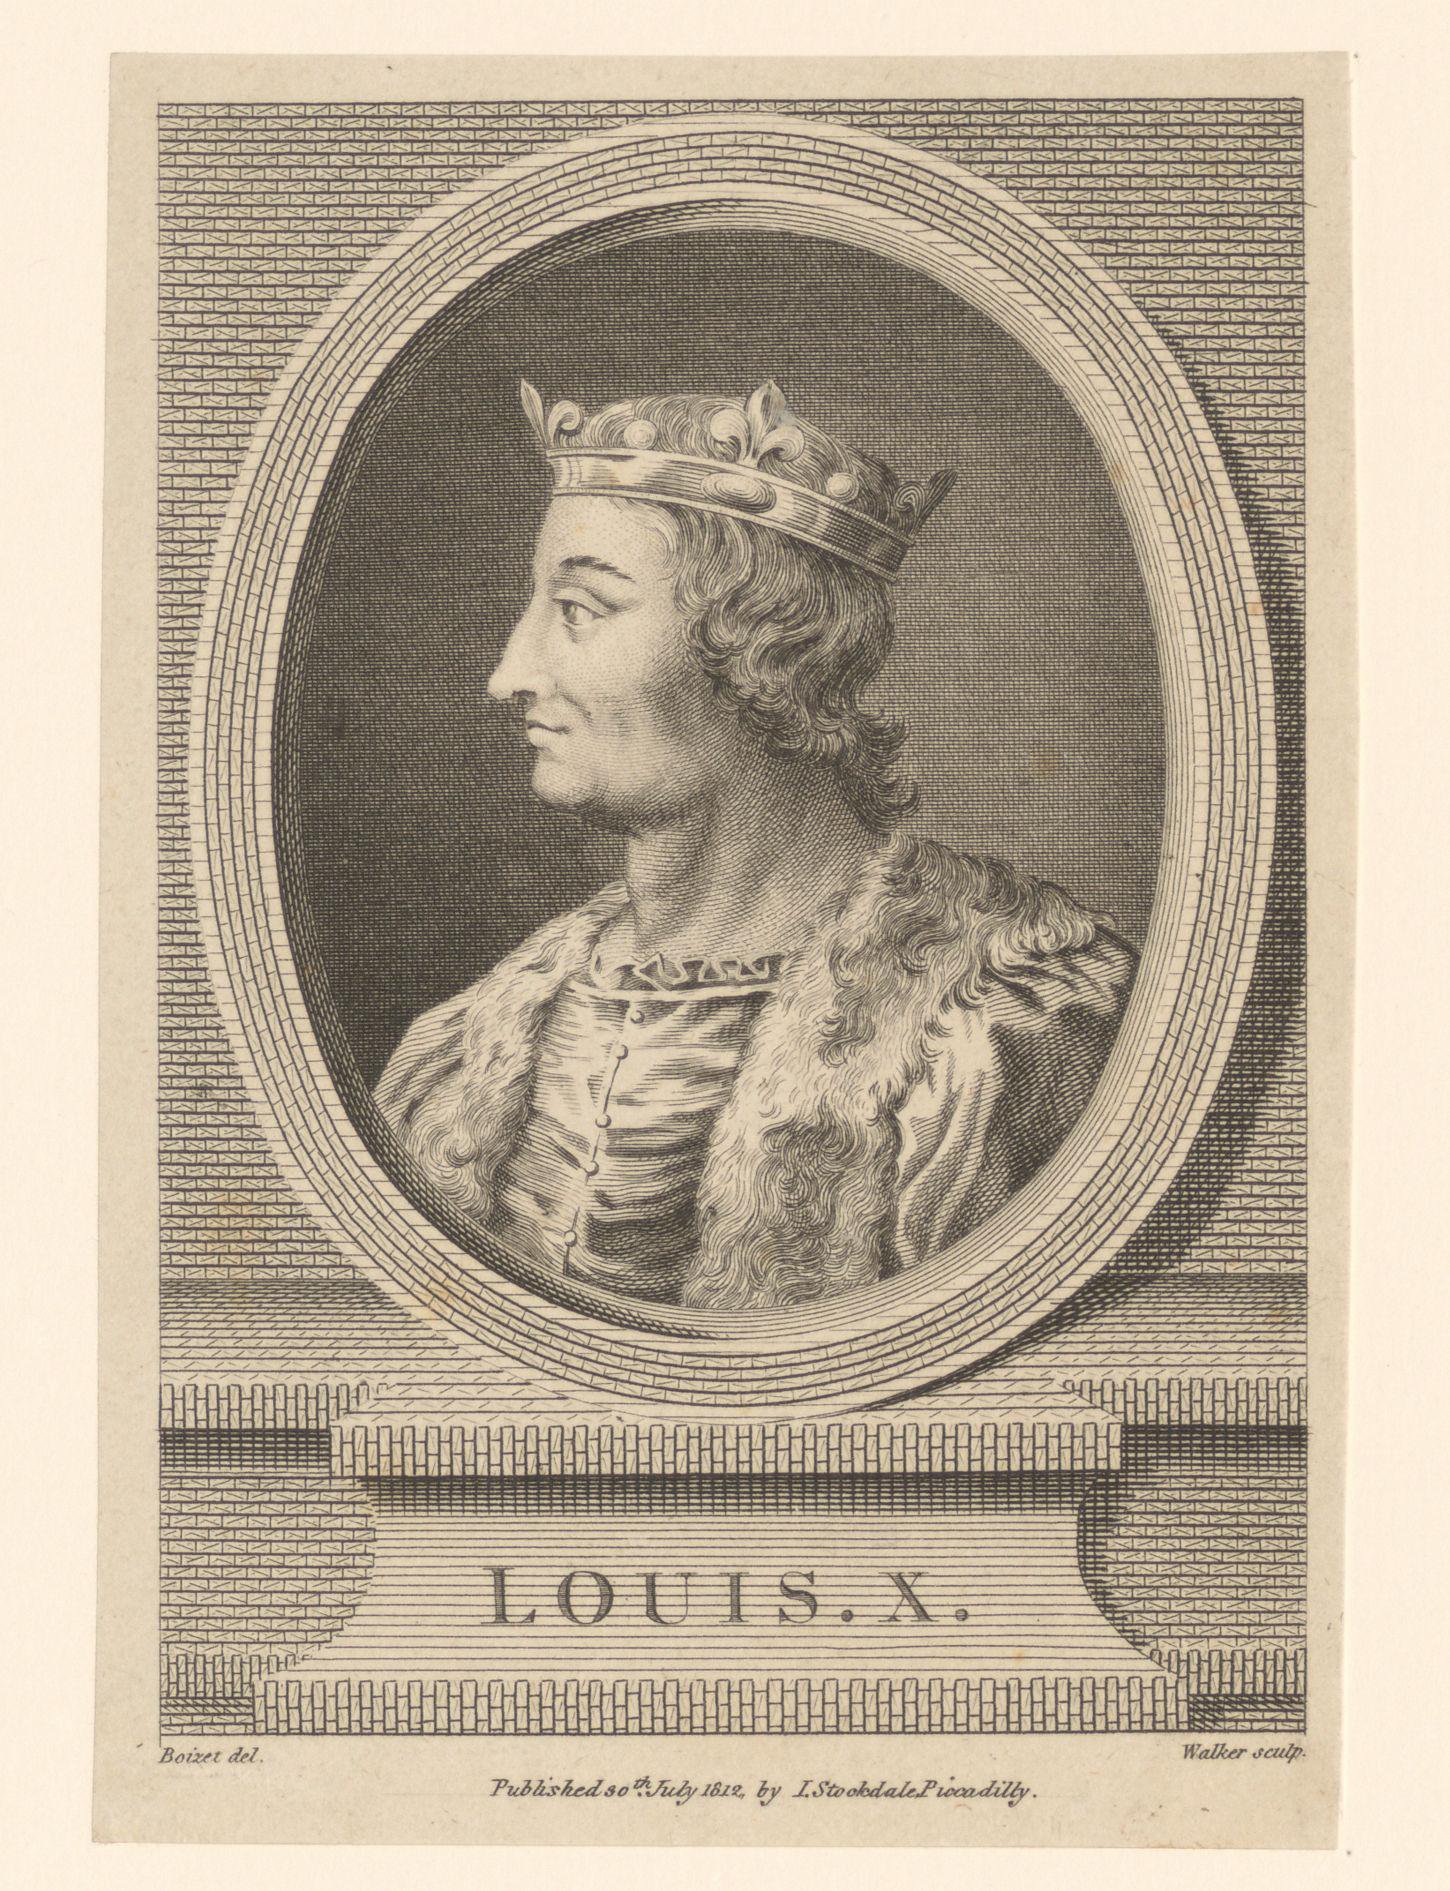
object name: print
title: Portret van Lodewijk X, koning van Frankrijk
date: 1812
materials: paper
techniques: engraving, etching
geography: london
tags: paris, historical persons, king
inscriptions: collector's mark: Lugt 2228